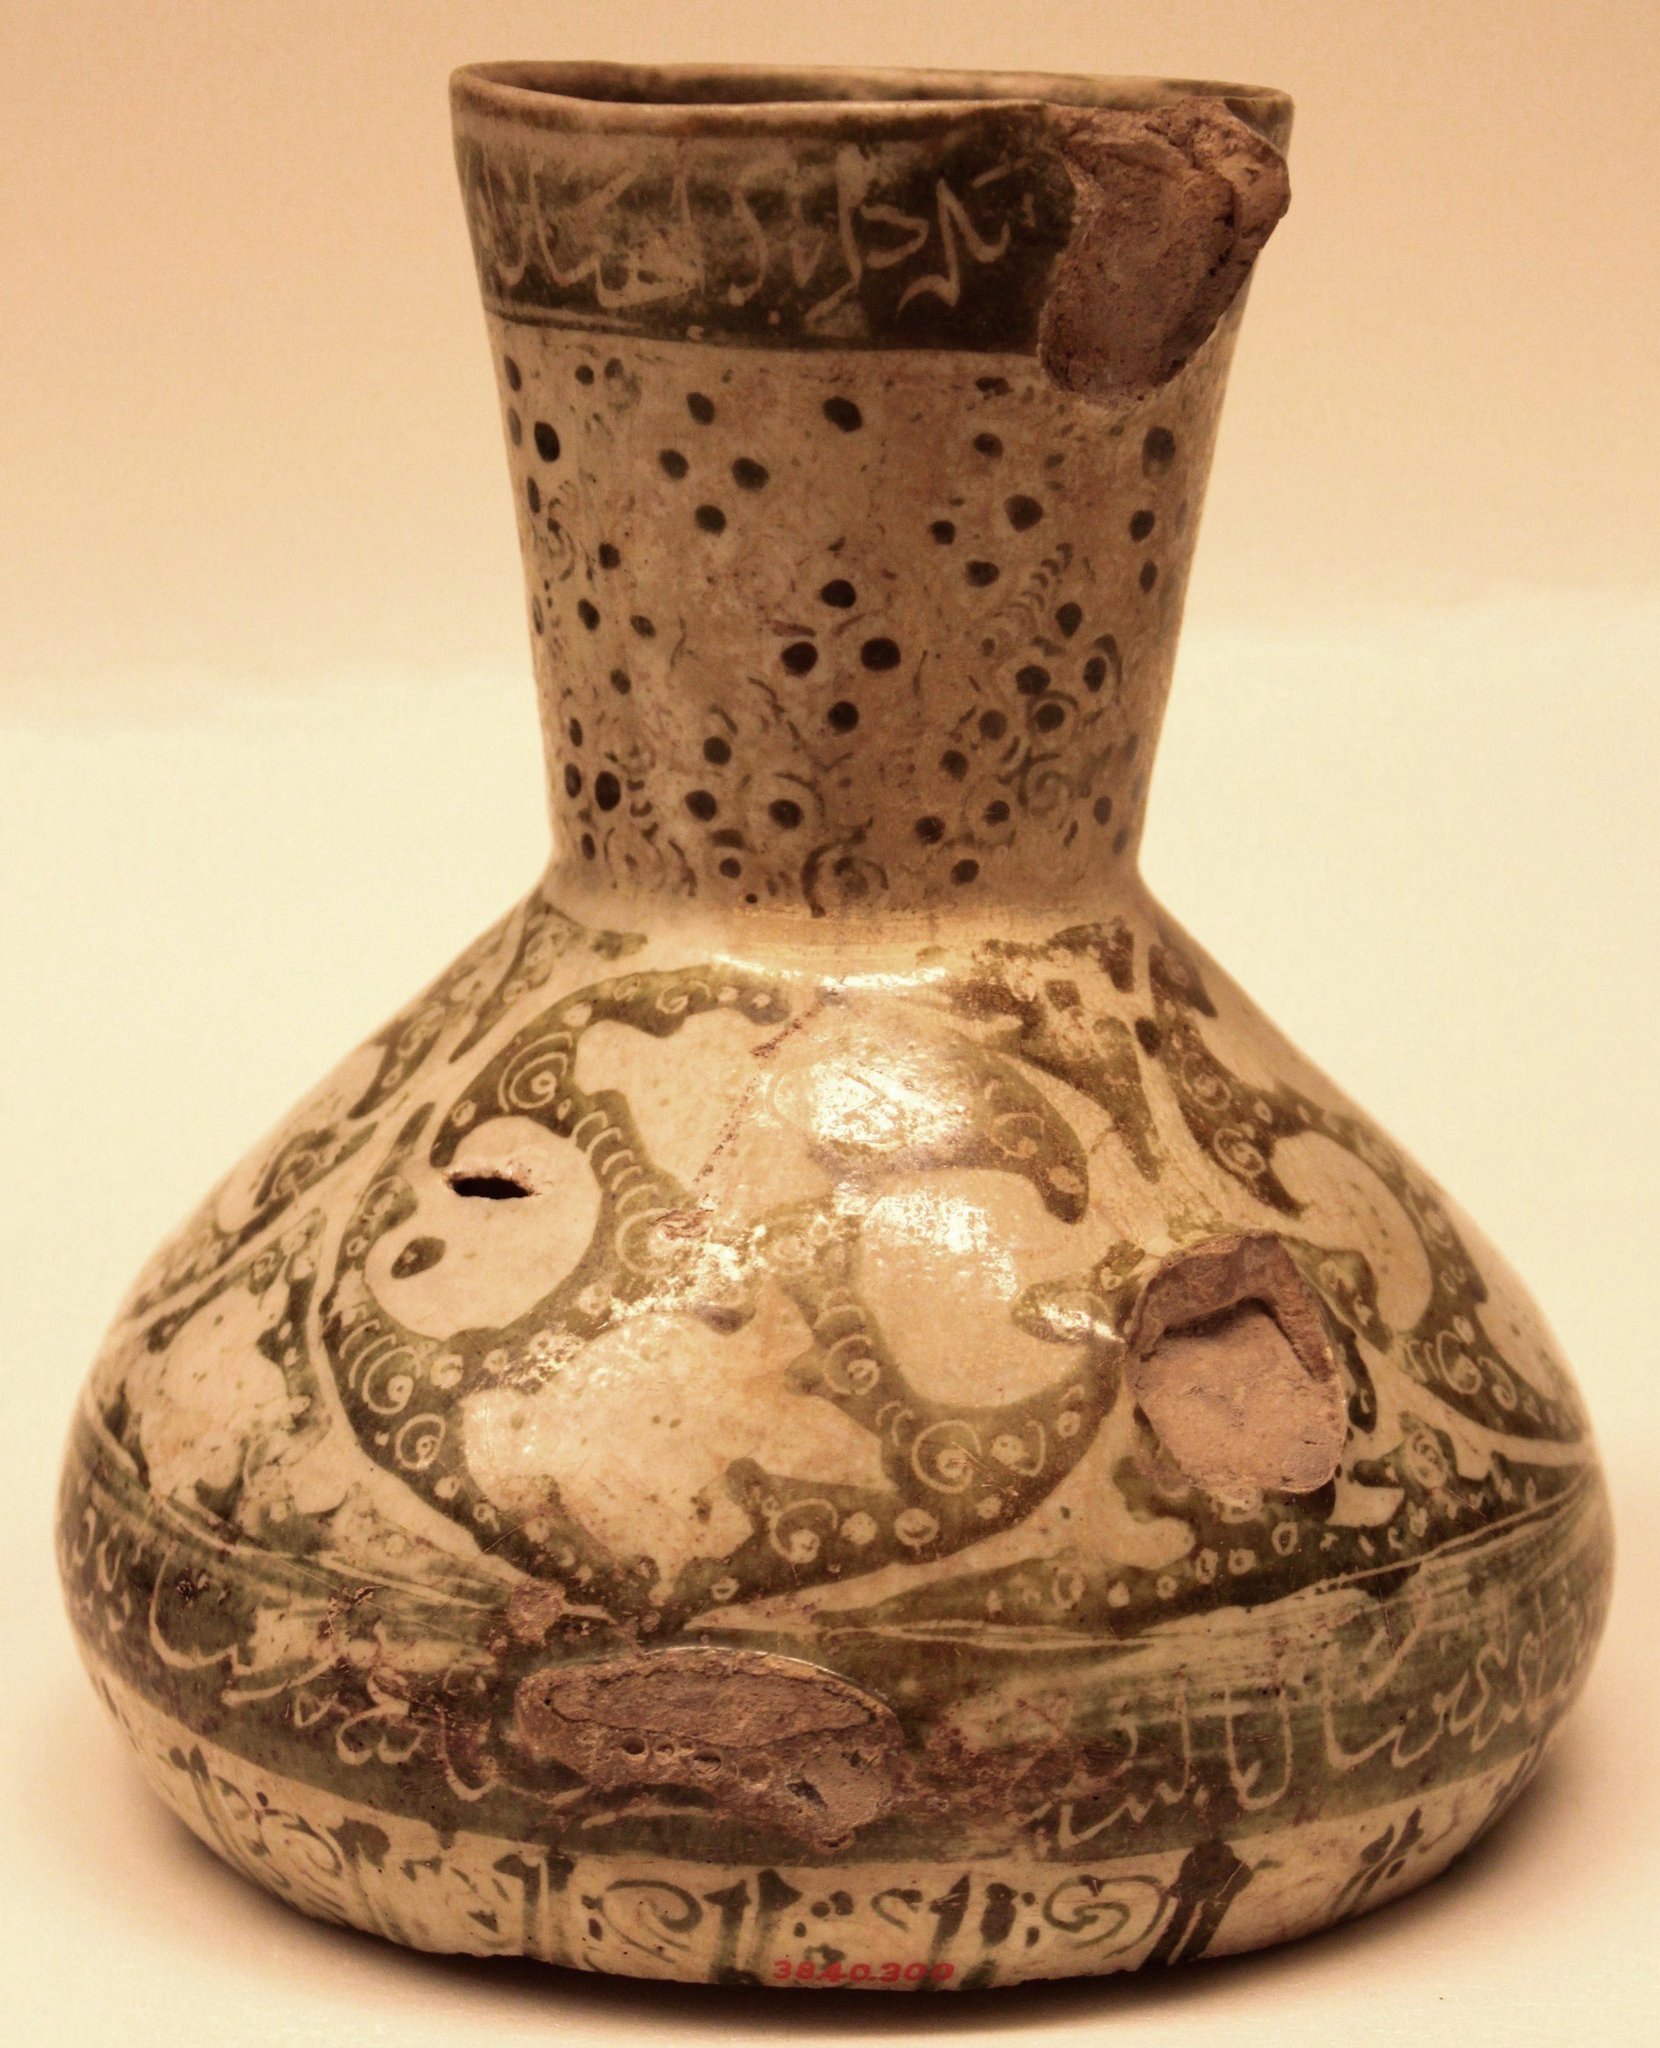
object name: fragment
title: Fragment of an Ewer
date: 701-800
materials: earthenware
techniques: luster painting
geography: iran